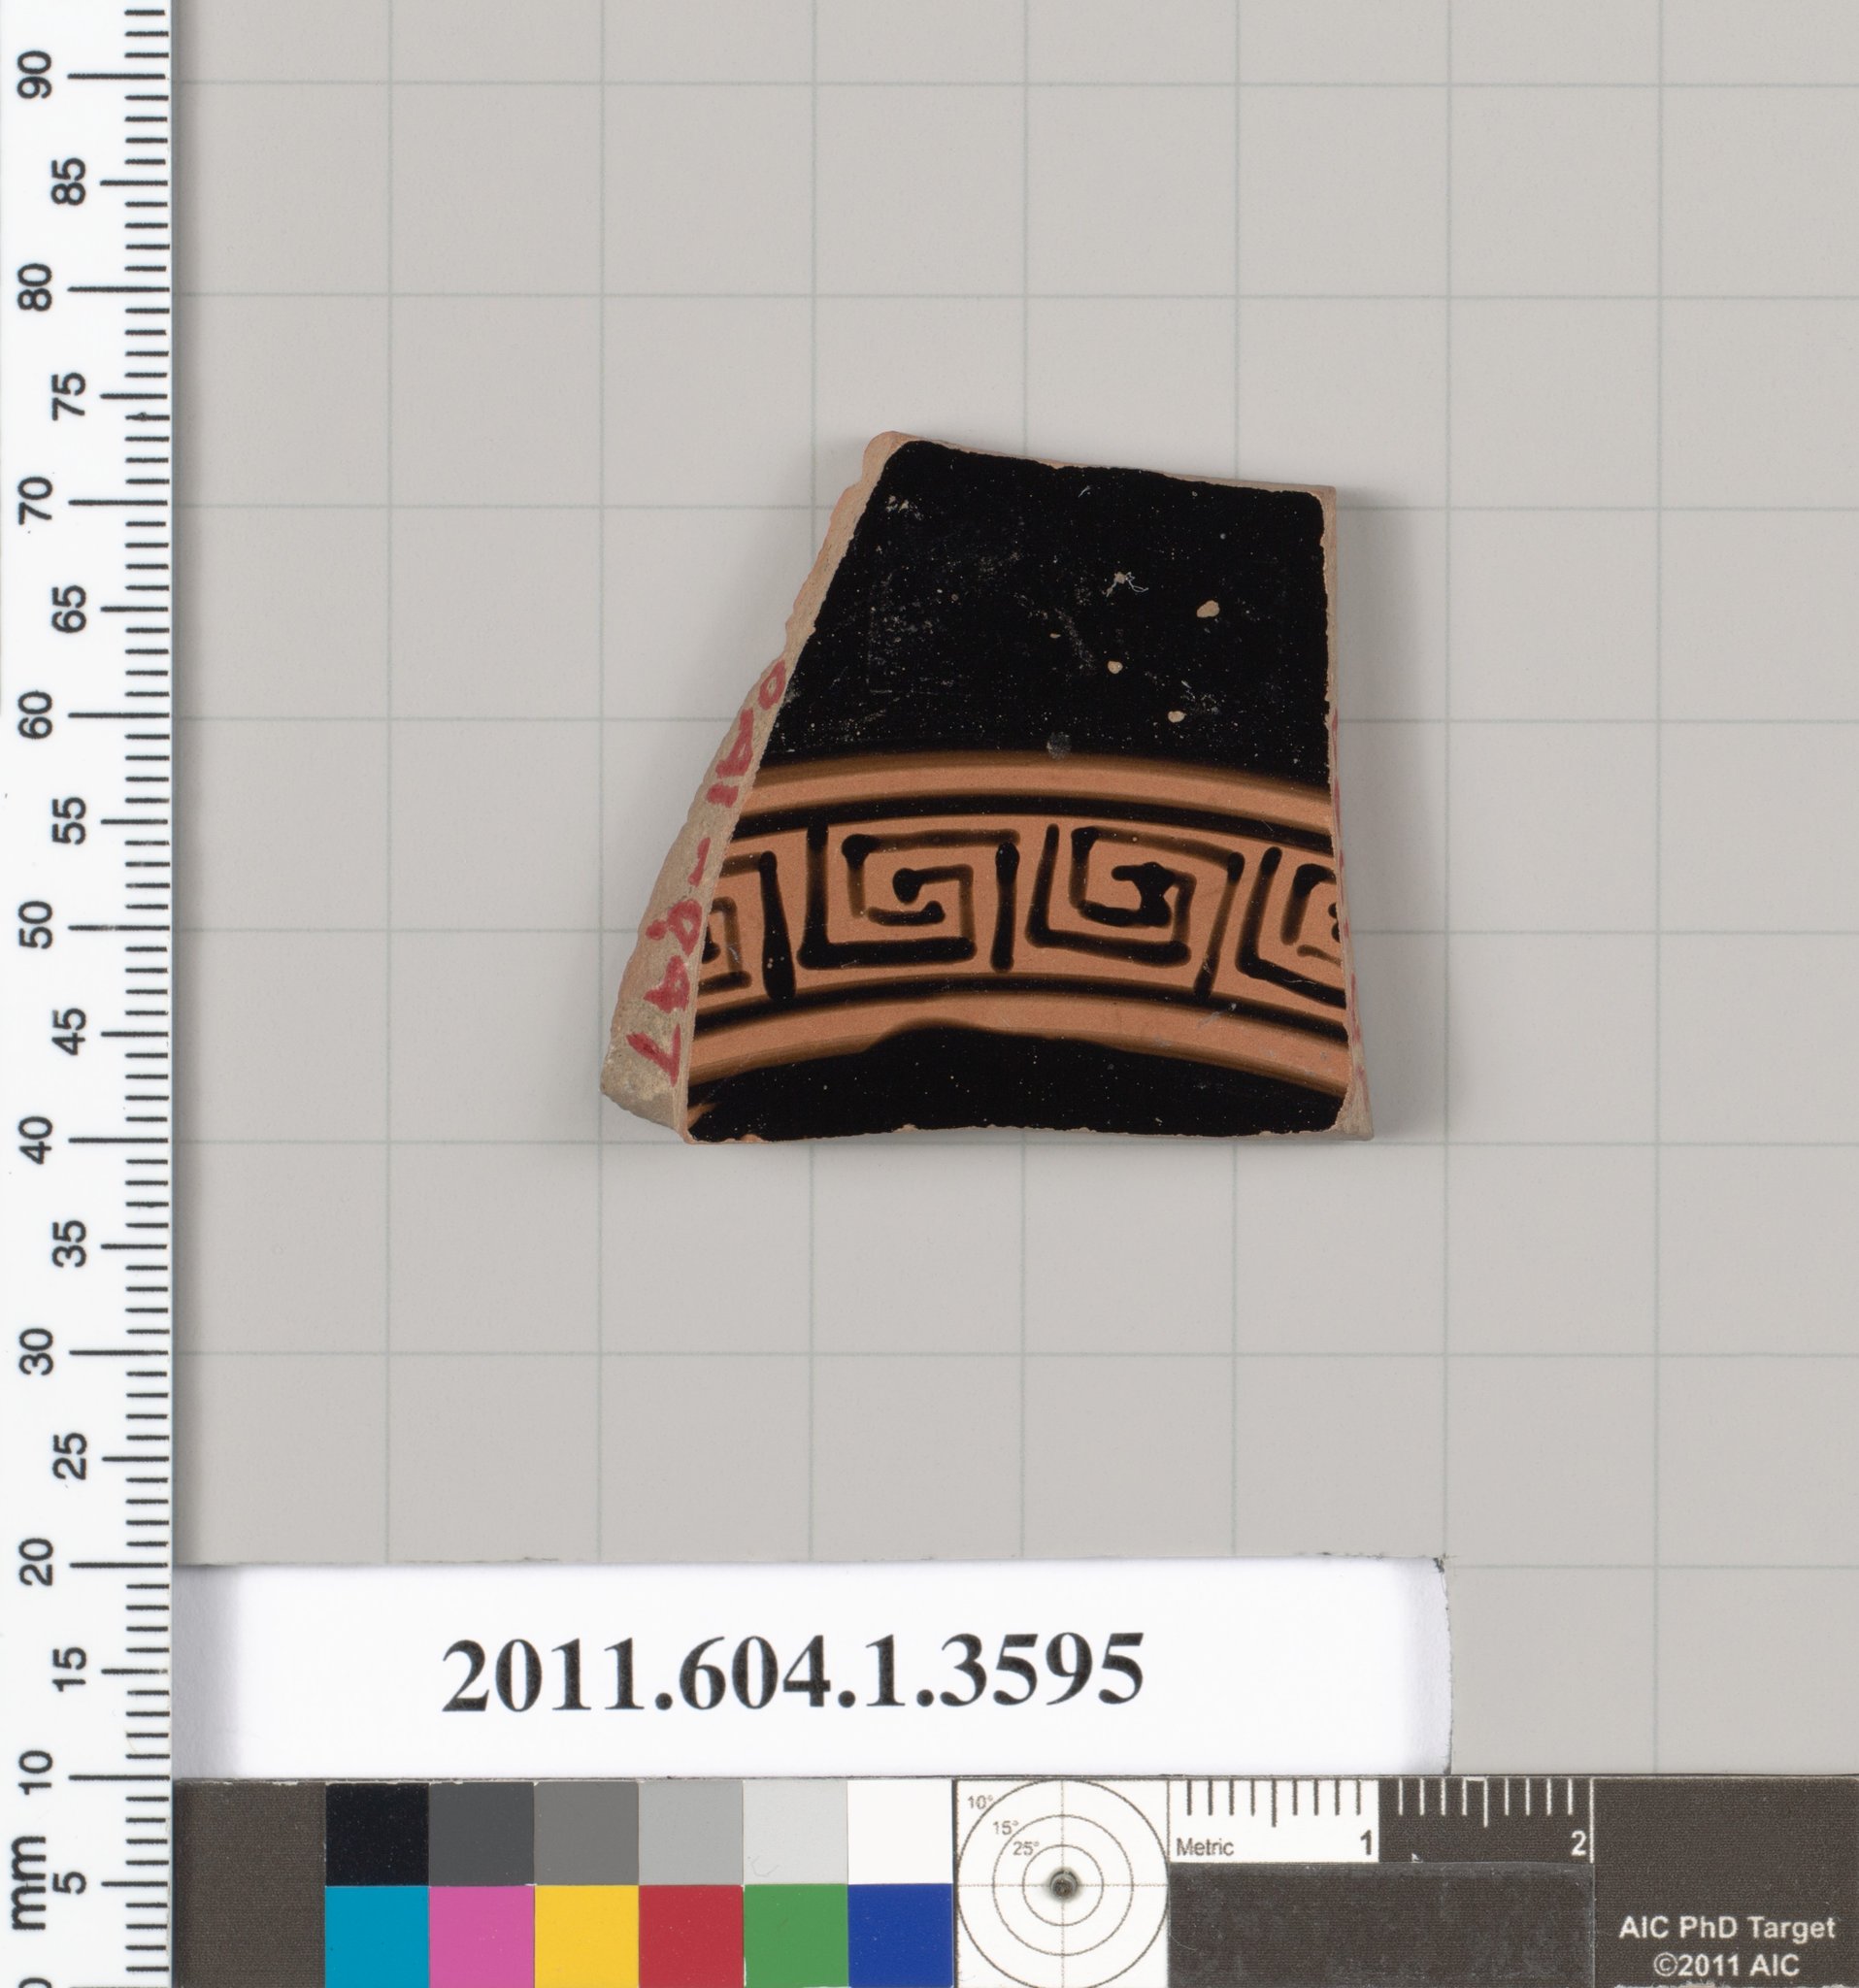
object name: kylix fragment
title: Terracotta fragment of a kylix (drinking cup)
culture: greek, attic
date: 490-470 BCE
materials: terracotta